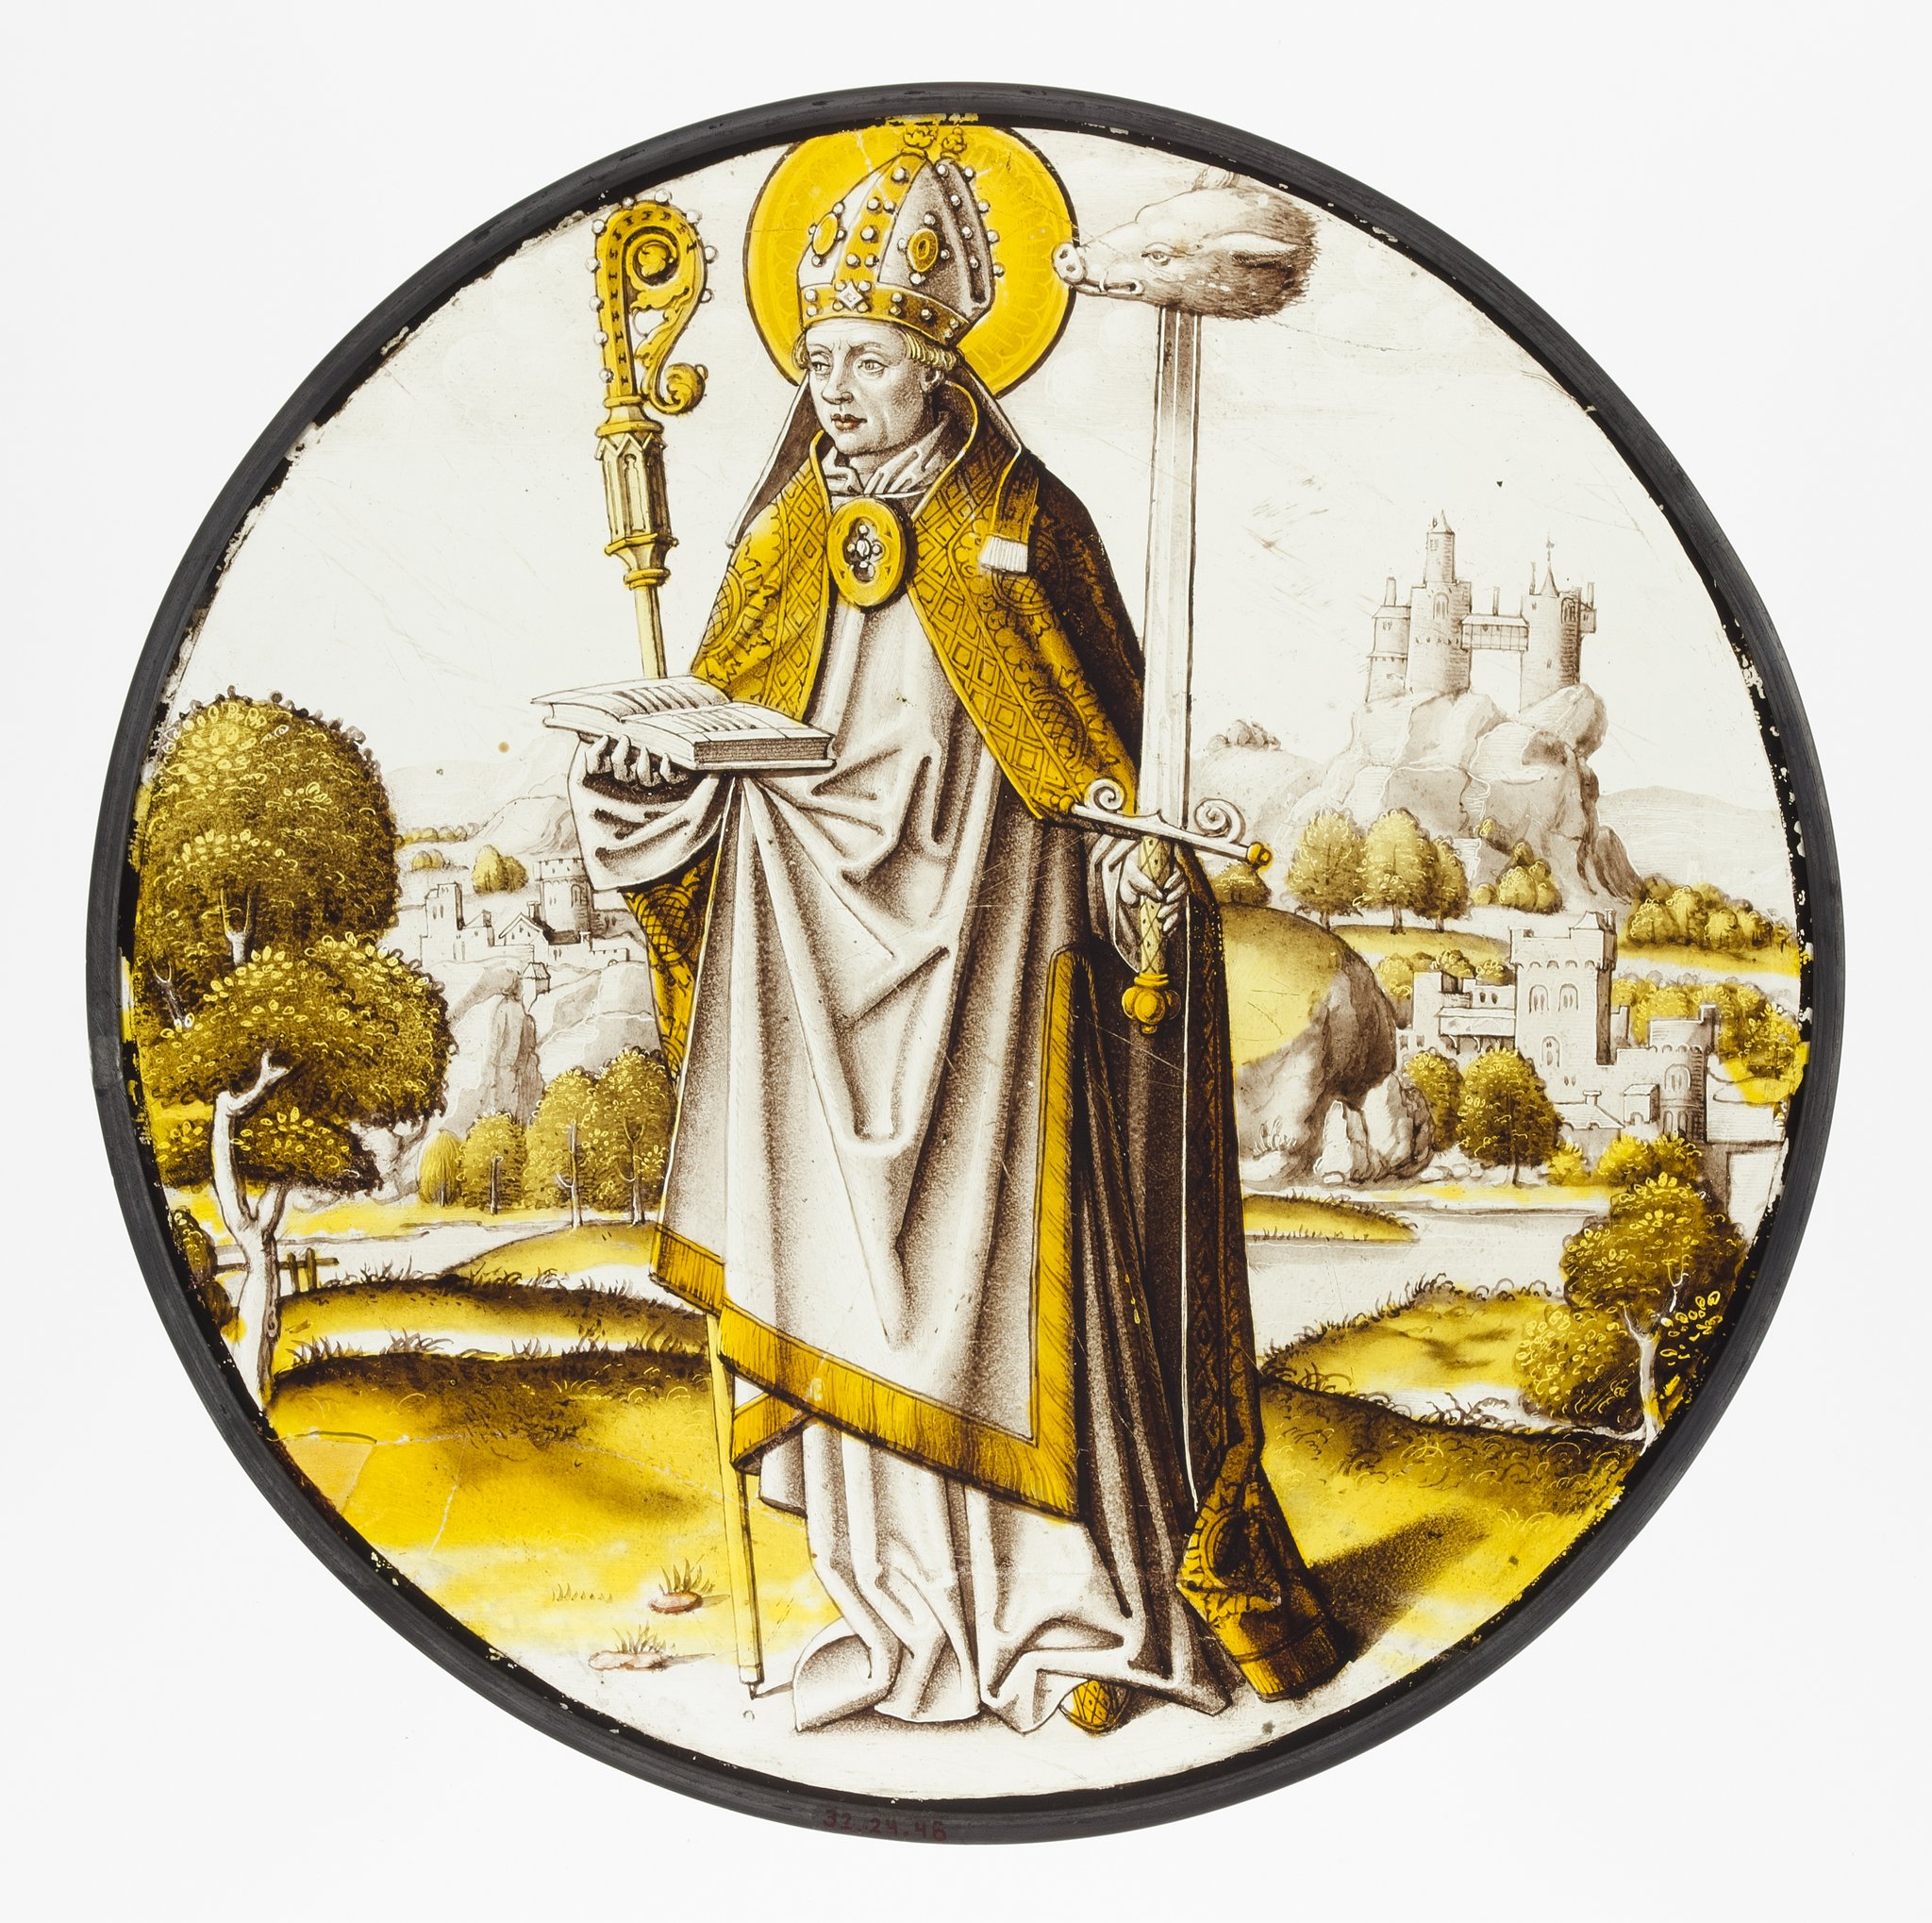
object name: roundel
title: Roundel with Saint Lambrecht of Maastricht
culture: south netherlandish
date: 1510-1520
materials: glass, paint, pigment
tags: books,swords,men,boars,saints